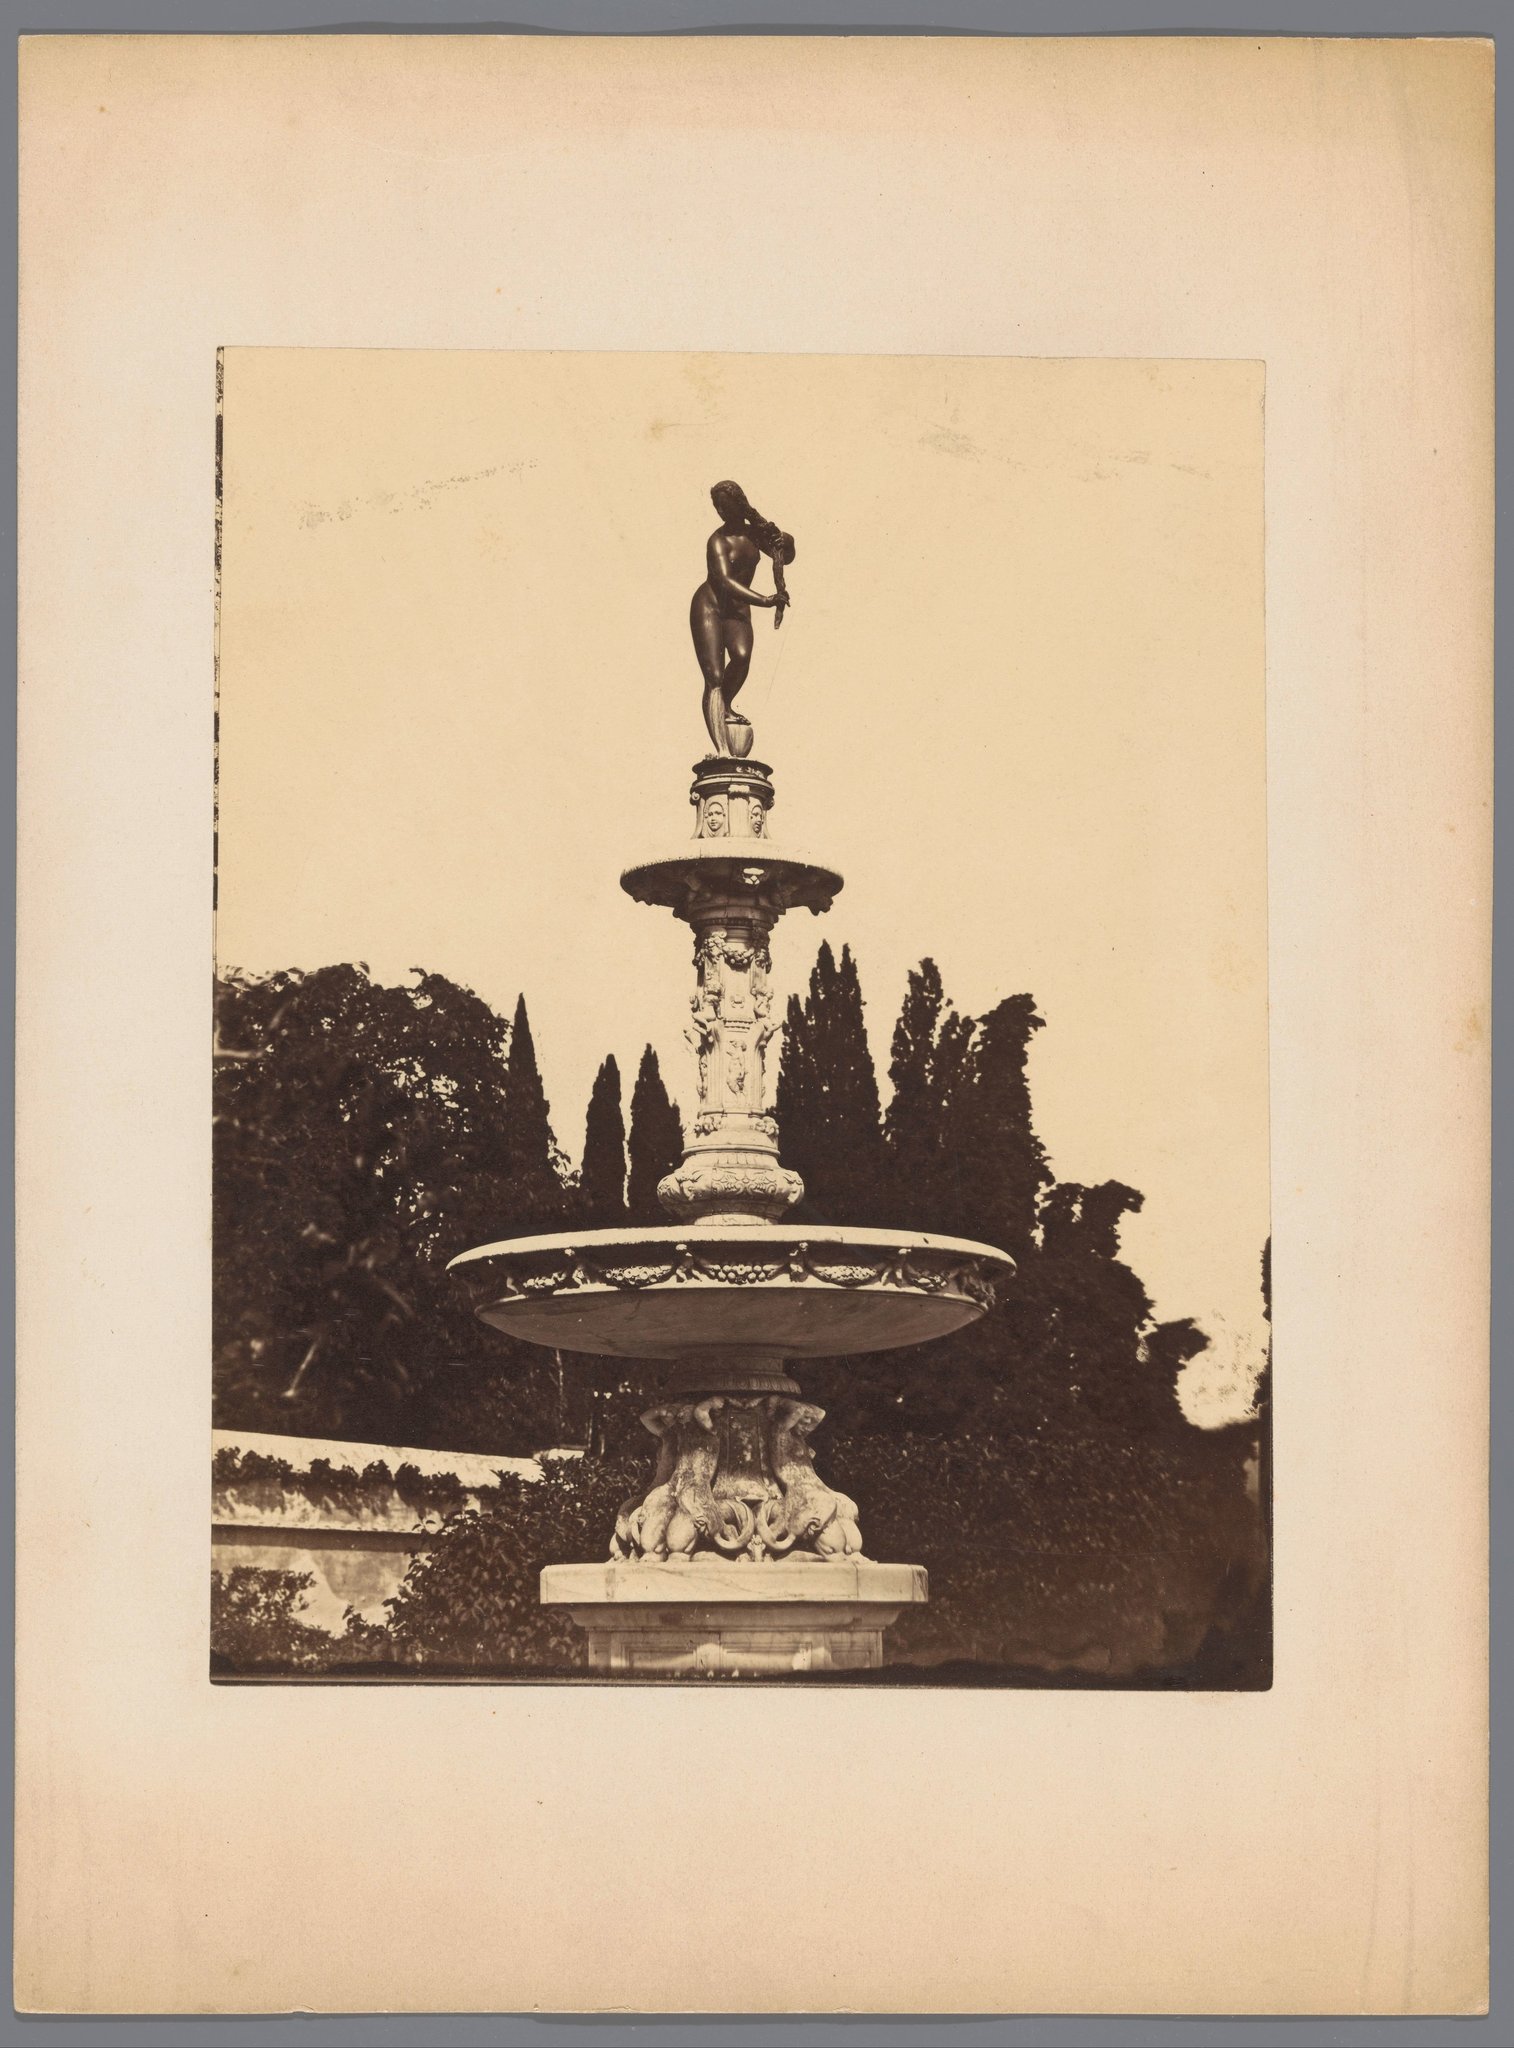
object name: photograph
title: Fontein in een tuin (vermoedelijk) te Rome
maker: gustave eugène chauffourier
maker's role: fotograaf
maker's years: 1845-1919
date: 1875-1900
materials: photographic support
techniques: albumen print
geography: rome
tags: woman (showing herself) undressed, quasi-nude, ornamental fountain, sculpture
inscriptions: collector's mark: Lugt 3937